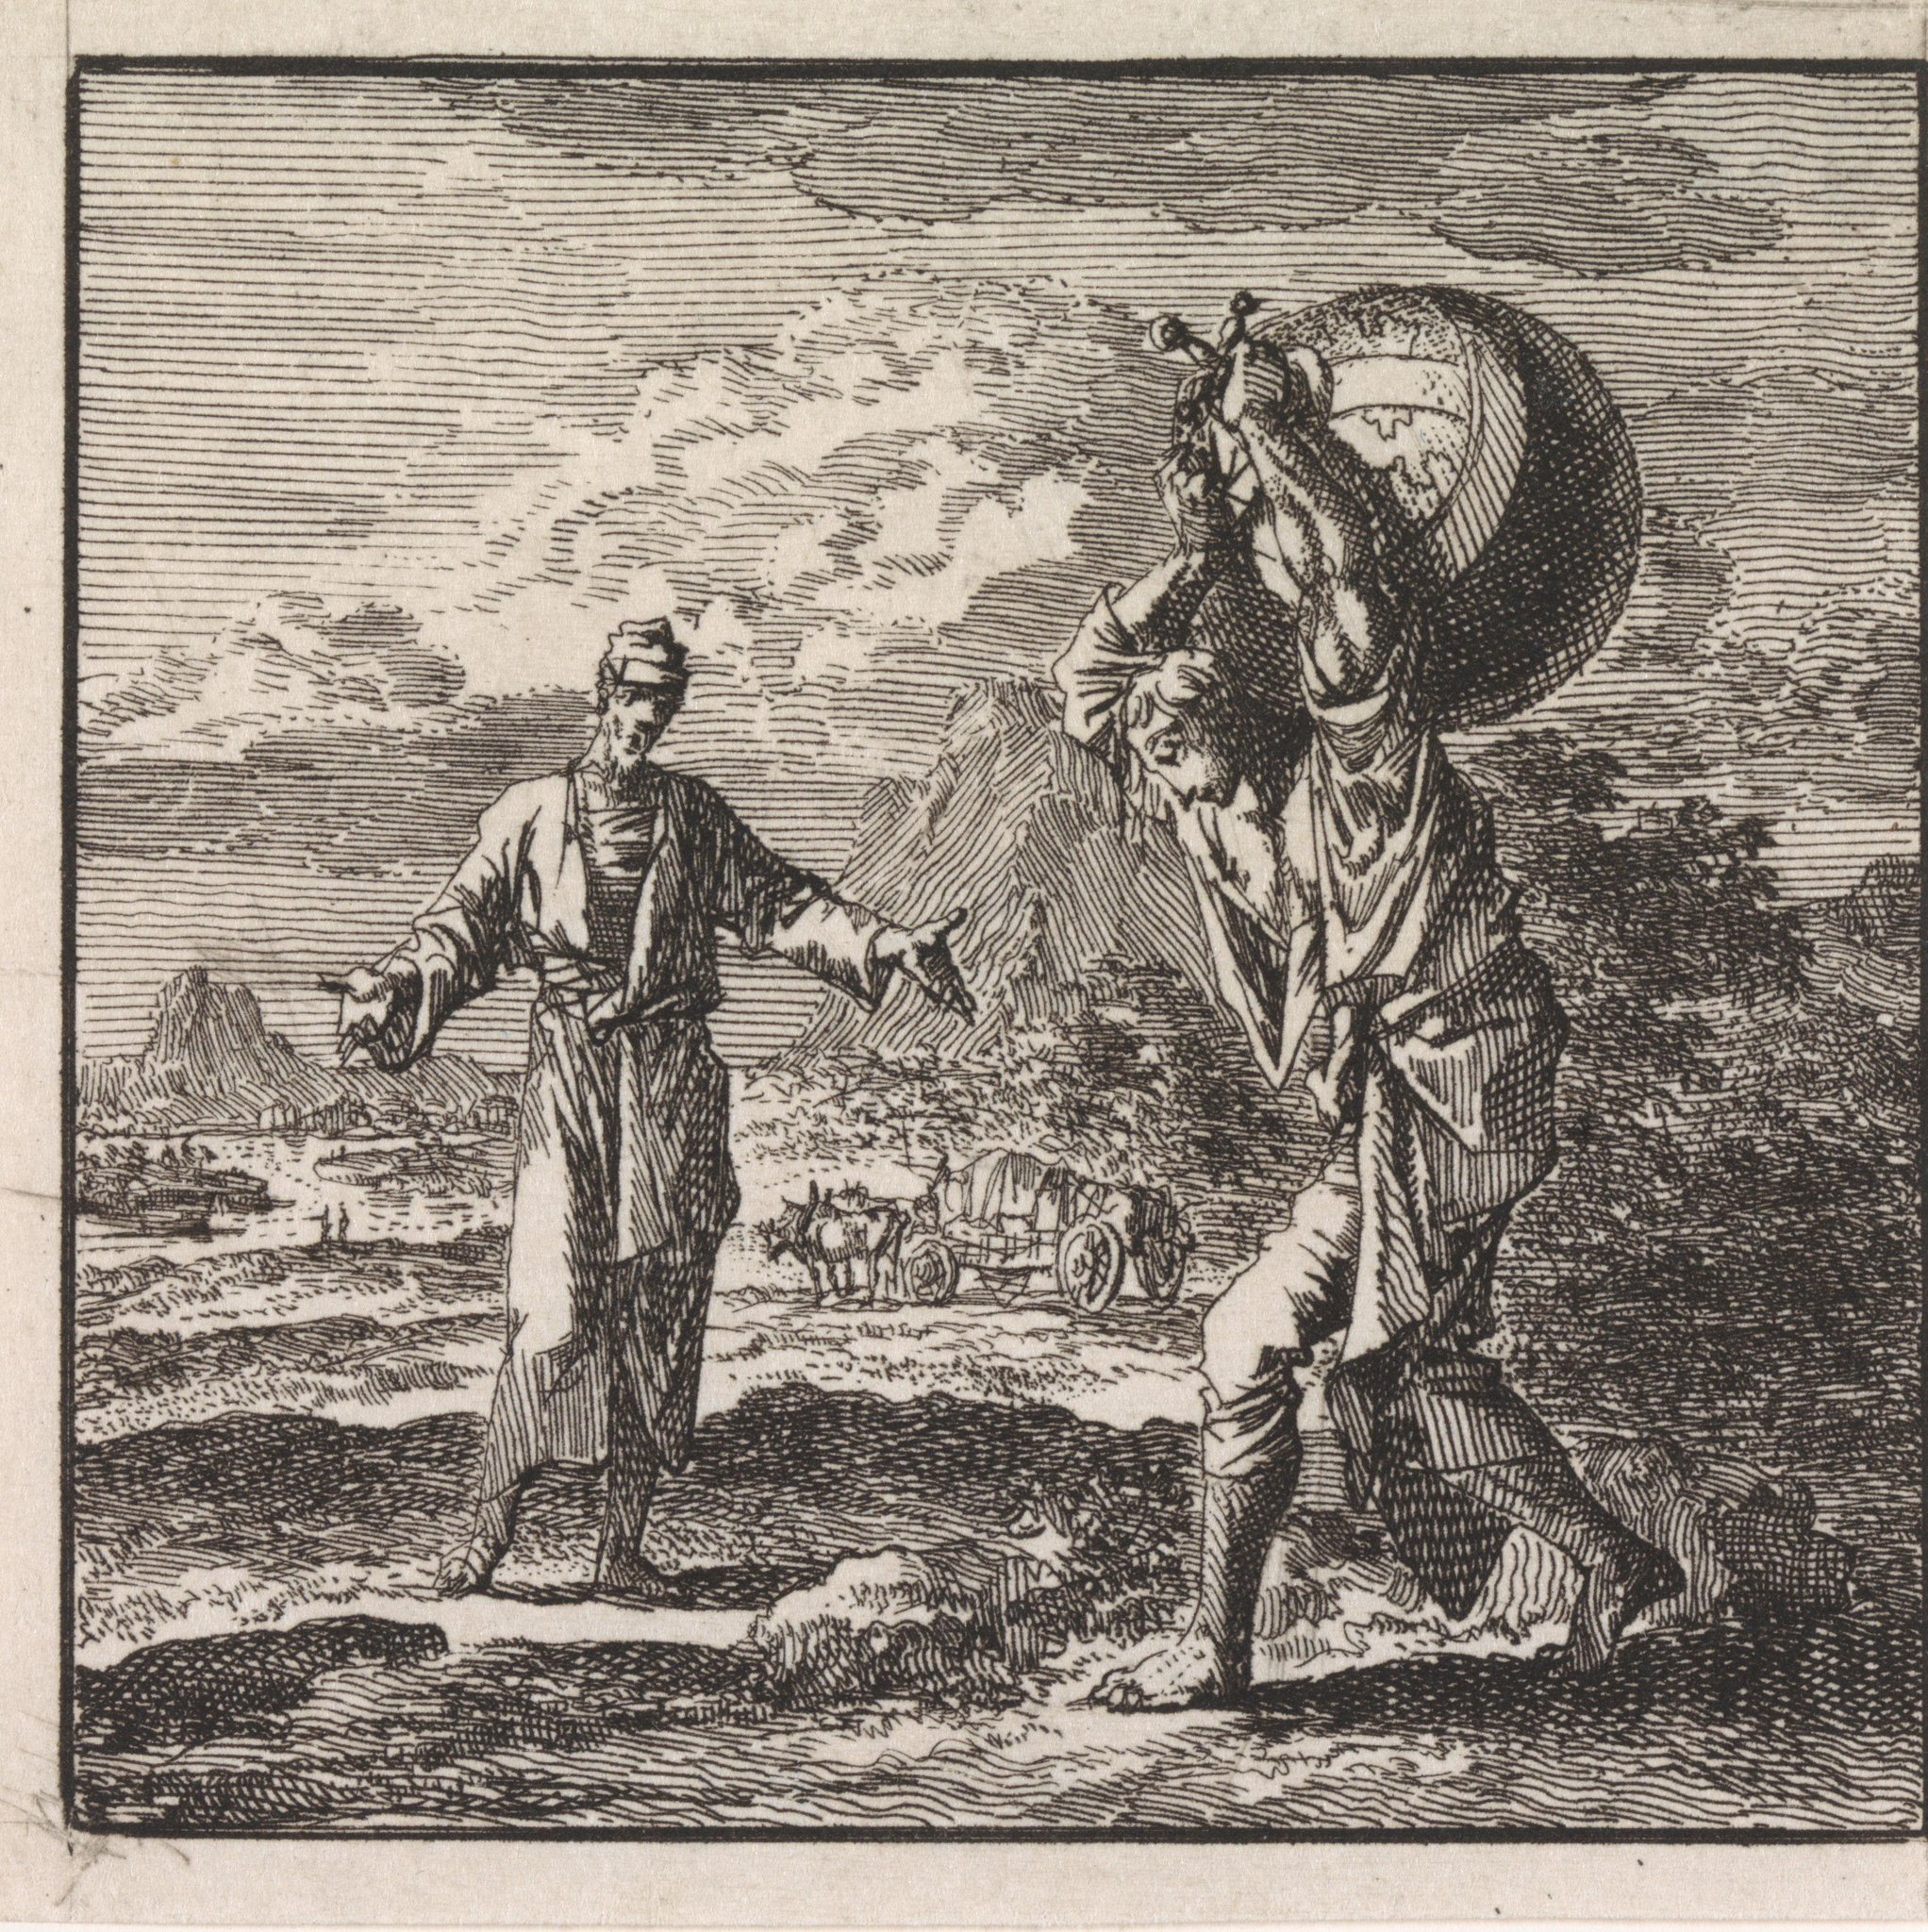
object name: print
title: Man draagt de wereld op zijn rug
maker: jan luyken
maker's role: draughtsman, print maker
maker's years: 1649-1712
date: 1710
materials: paper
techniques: etching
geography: amsterdam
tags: earth, world as celestial body, carrying something on the head or on the shoulders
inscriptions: collector's mark: Lugt 2228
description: Proefdruk voor illustratie uit: Luyken, Jan. De onwaardige wereld, vertoond in vyftig zinnebeelden, met godlyke spreuken en stichtelyke verzen. Amsterdam: Pieter Arentsz. II (wed.) en Cornelis van der Sys, 1710, p. 140.